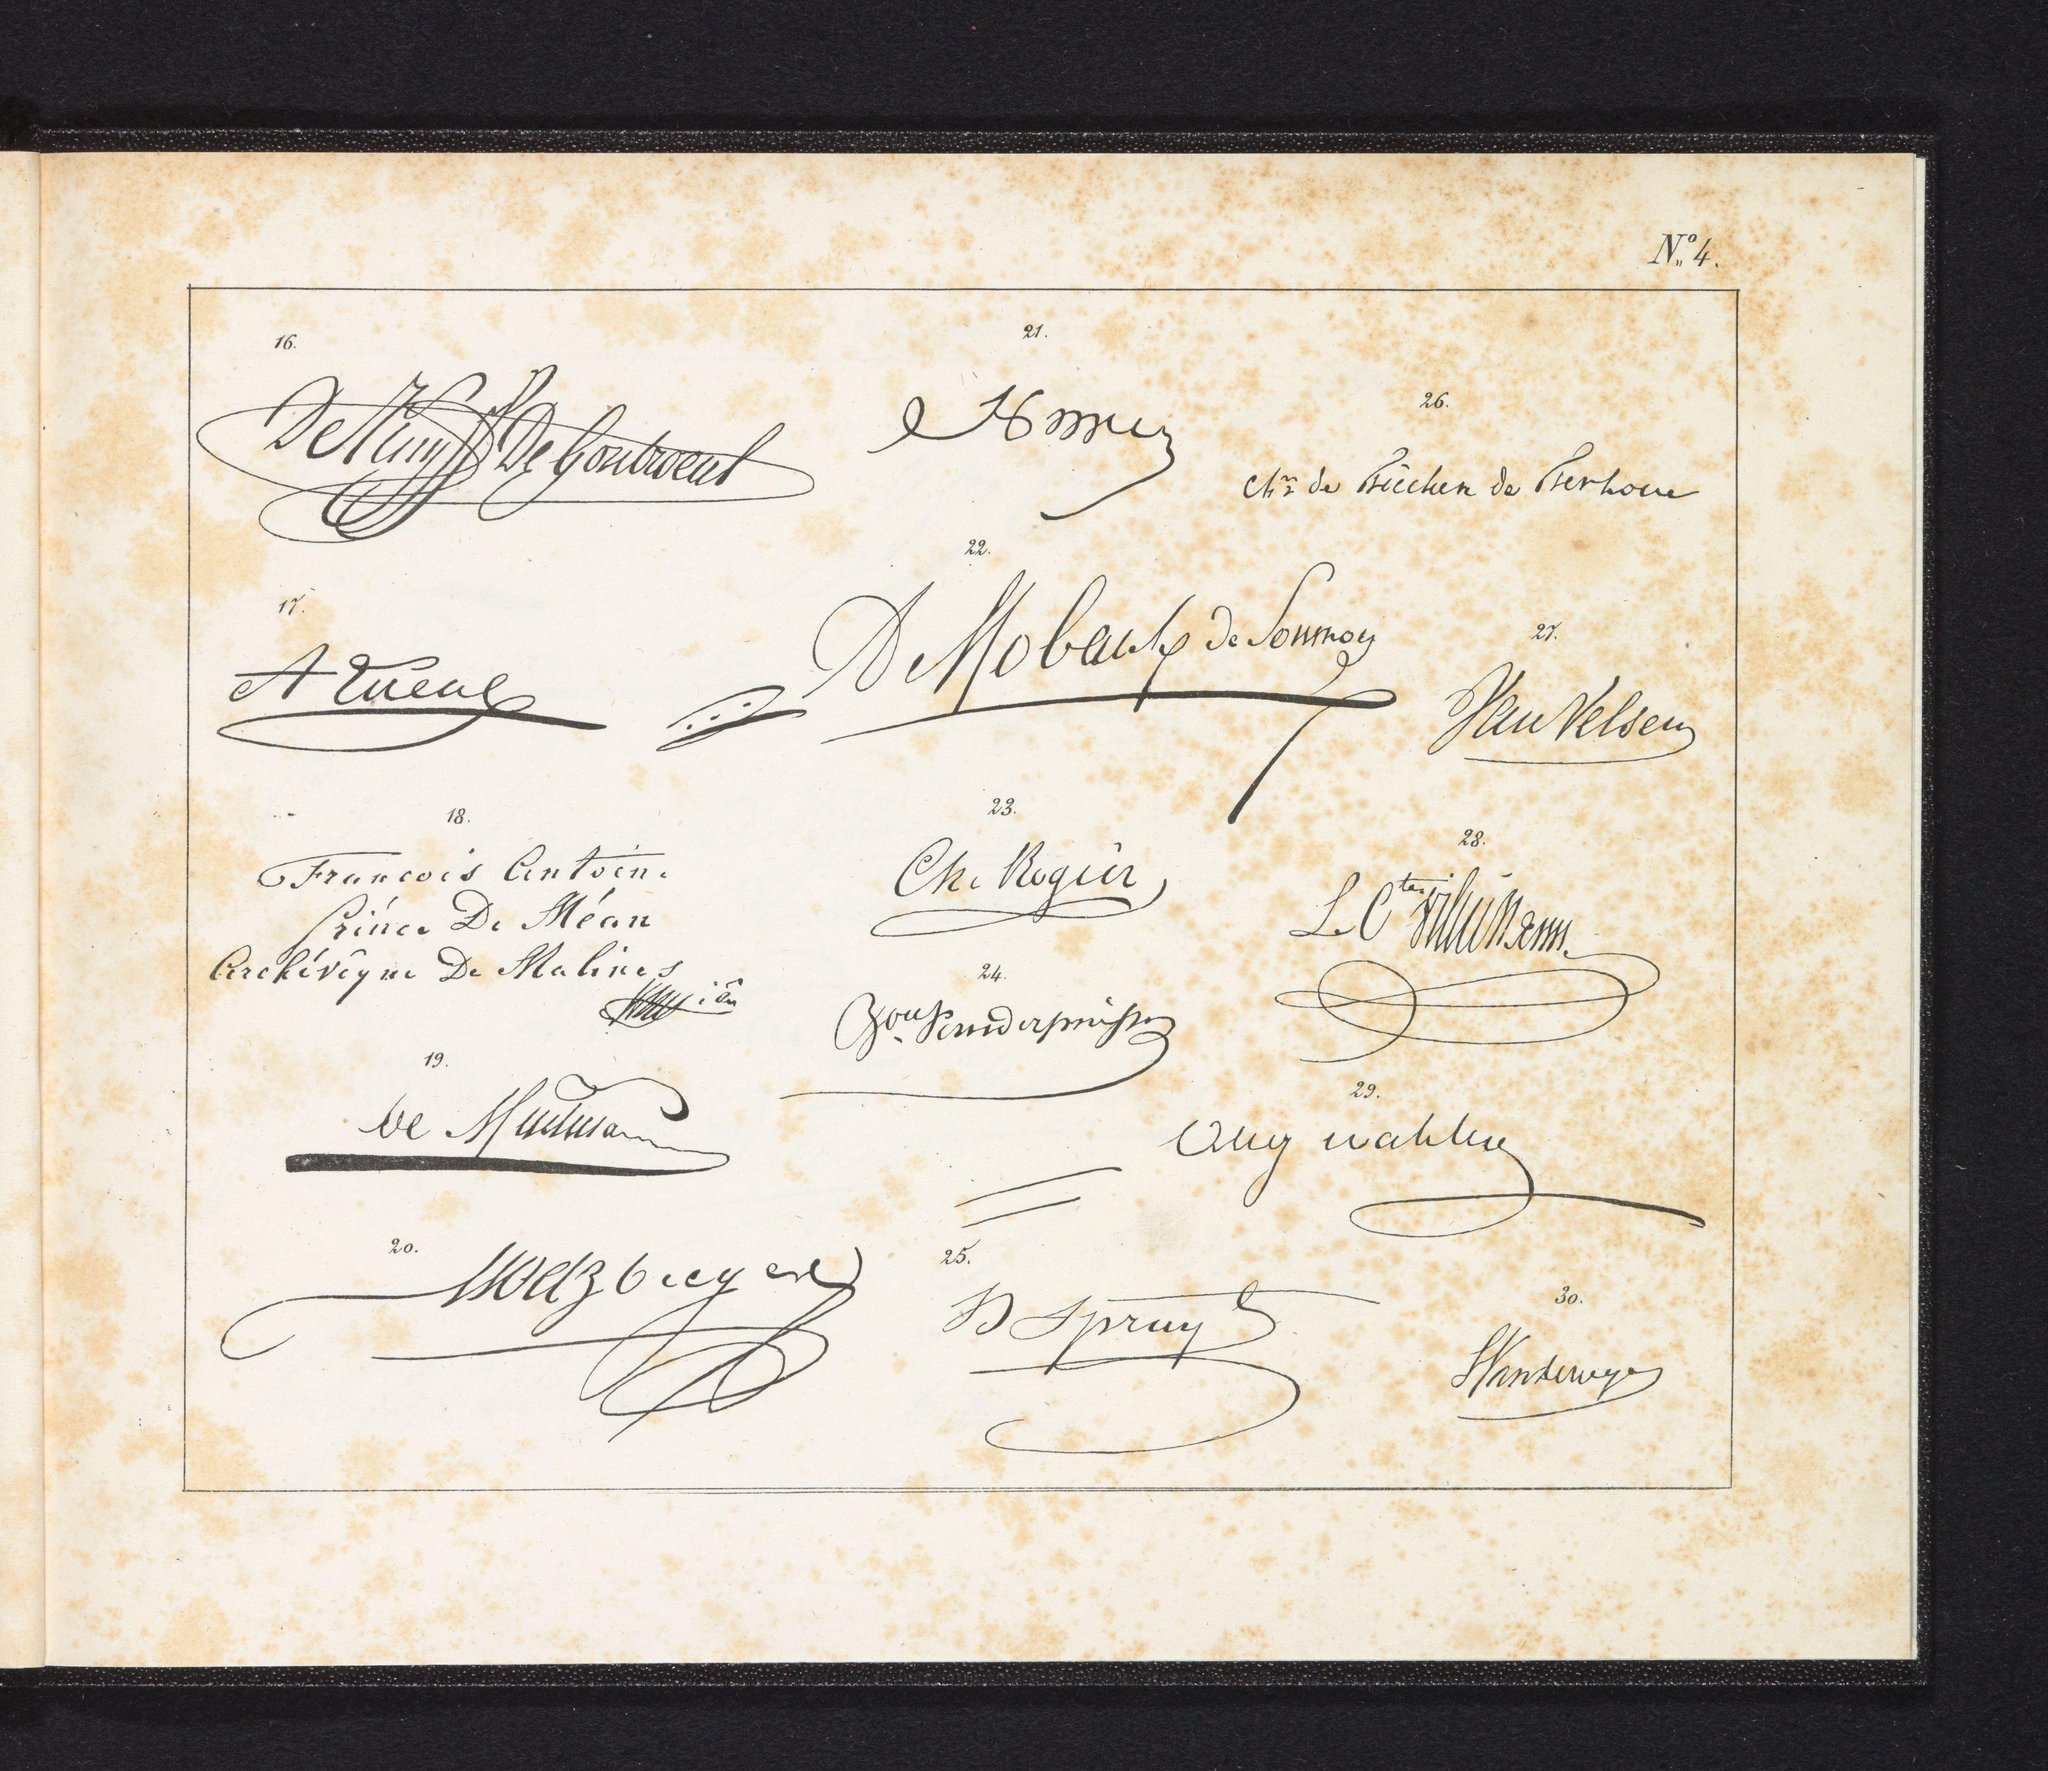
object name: print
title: Handtekeningen van Belgen, 1830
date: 1830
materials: paper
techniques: lithograph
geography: netherlands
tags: handwriting, written text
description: Facsimiles van de handtekeningen van vijftien Belgen en ambtenaren in België. Illustratie in een bundel van twee cahiers met facsimiles van de handtekeningen van hoofdrolspelers in de Belgische Revolutie in 1830.